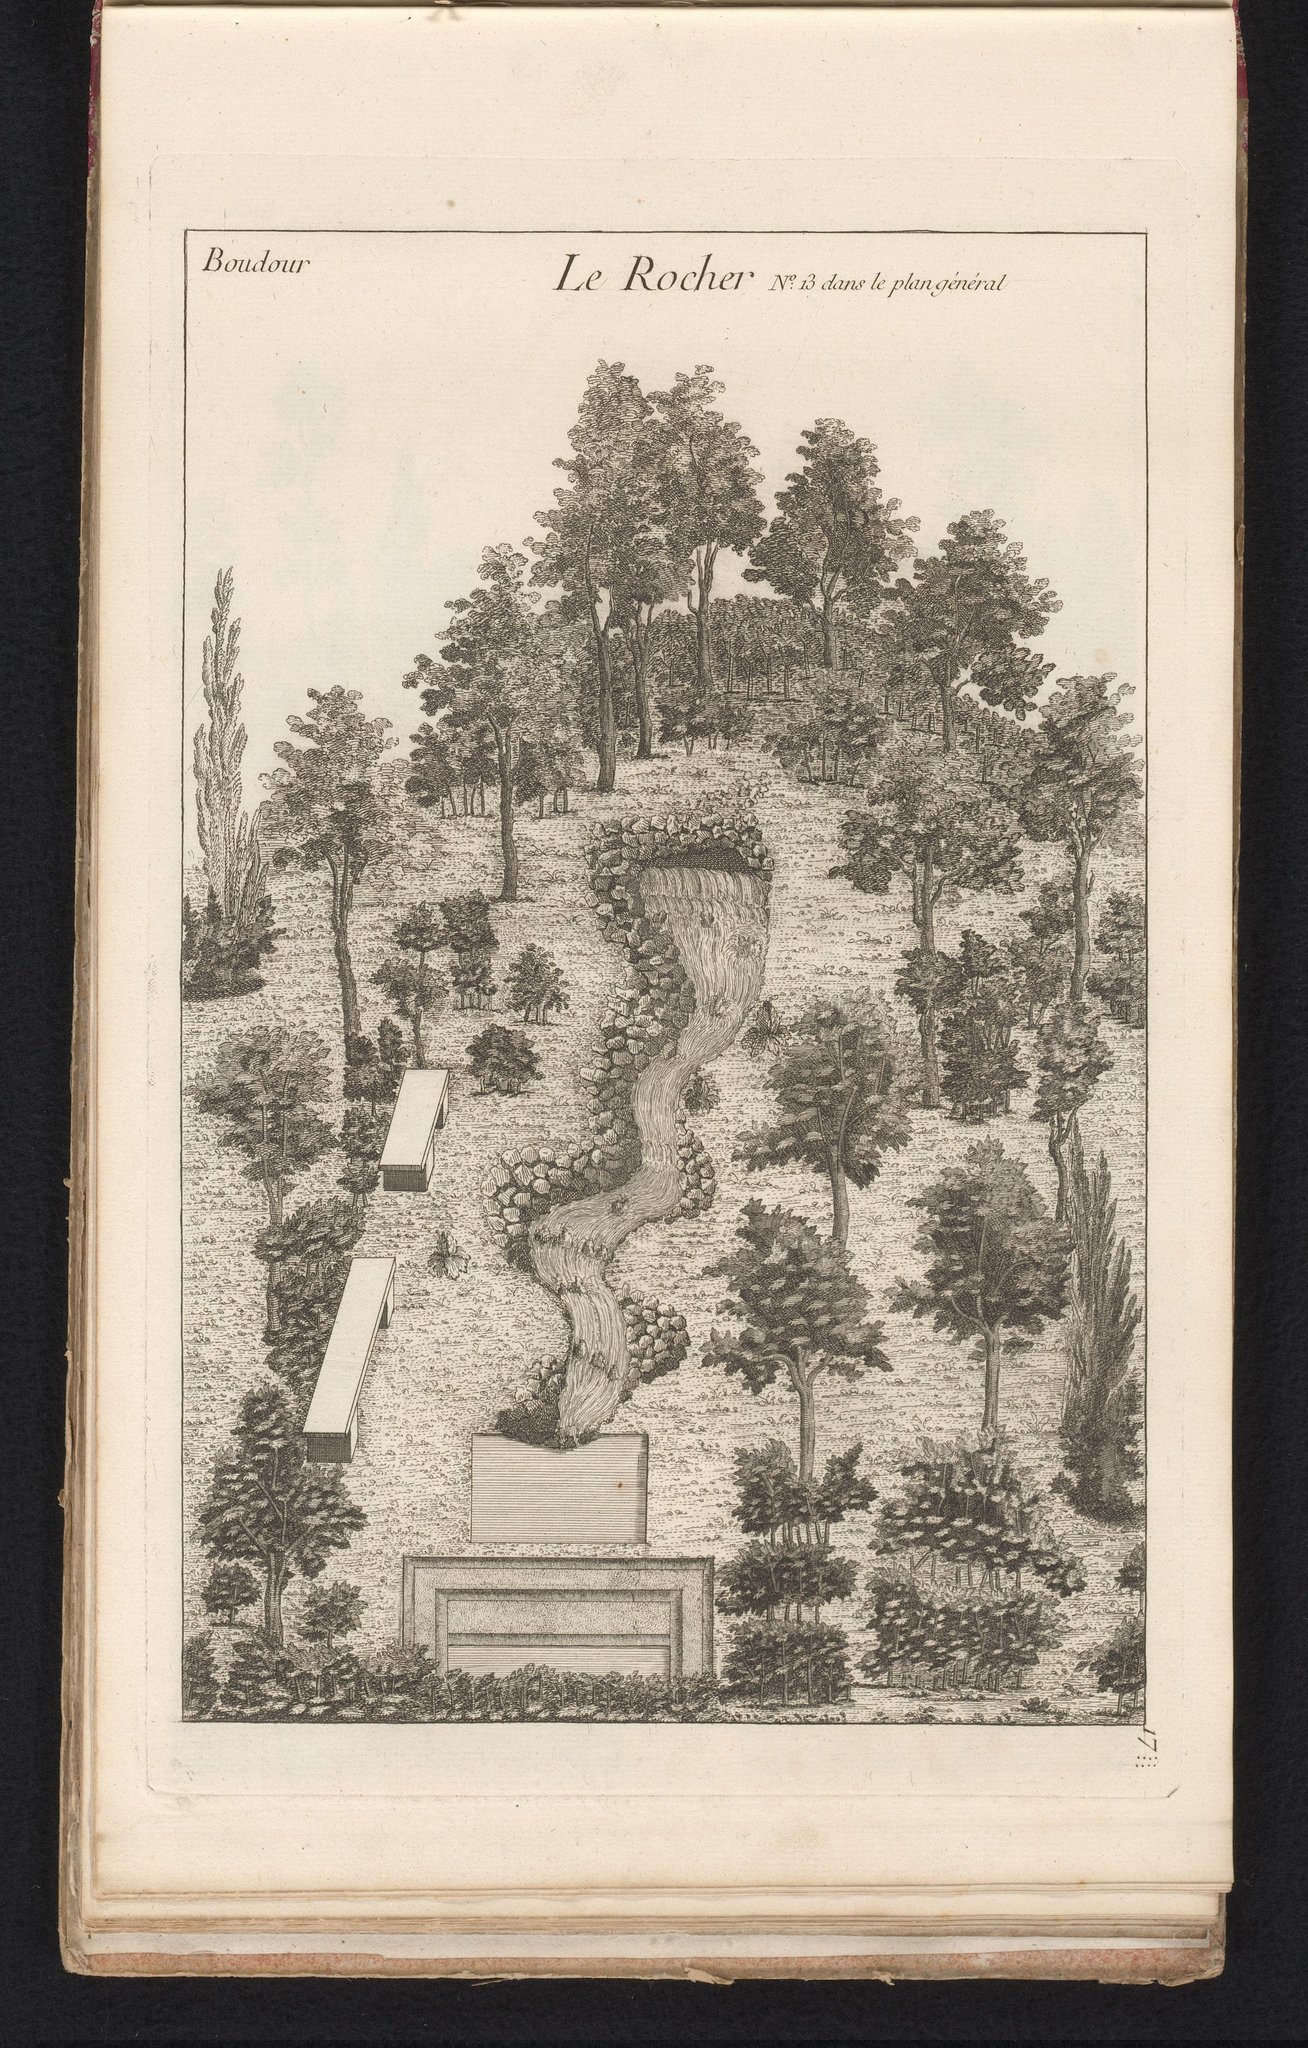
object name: album leaf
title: Gezicht op een waterloop tussen rotsen in de tuin van het kasteel van Baudour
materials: paper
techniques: engraving, etching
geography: paris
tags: garden cascade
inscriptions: collector's mark: Lugt 2228, collector's mark: Lugt 2760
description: De serie 'Jardins anglo-chinois à la mode' verscheen in totaal in 21 zogeheten 'cahiers' (afleveringen). De huidige prent komt uit het achtste 'cahier'. Het Rijksmuseum Amsterdam bezit drie banden met daarin in totaal zes 'cahiers' van deze reeks. In de documentatie wordt verwezen naar een in de bibliotheek van het Rijksmuseum Amsterdam aanwezige facsimile van het complete werk.